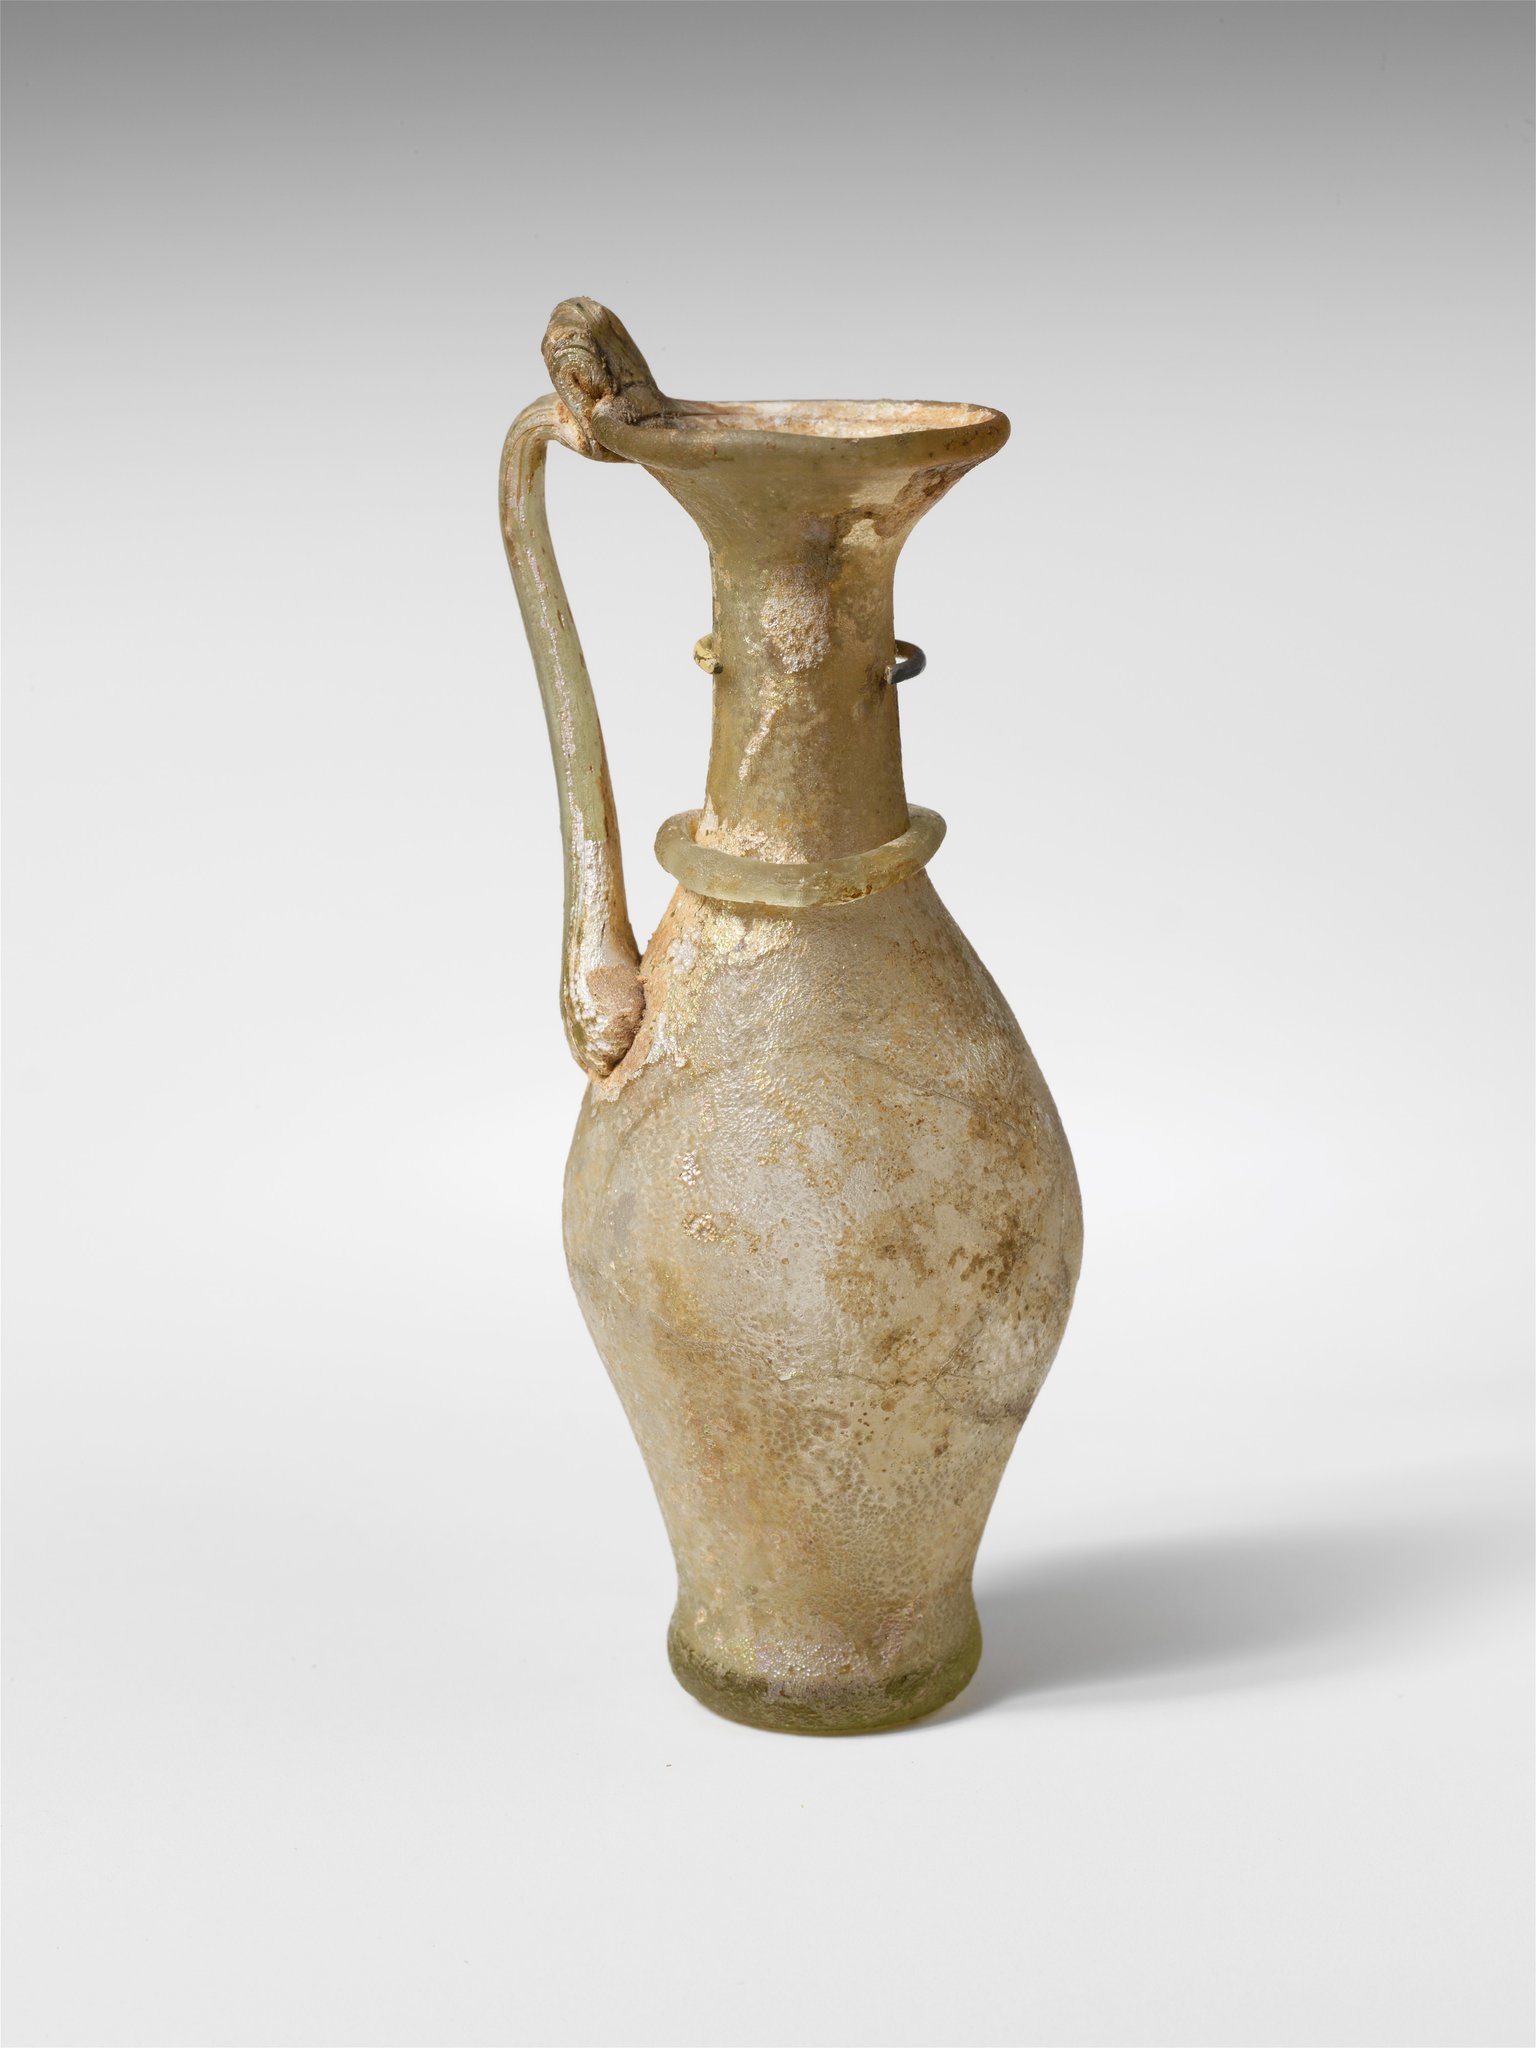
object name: jug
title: Glass jug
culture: roman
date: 301-400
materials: glass